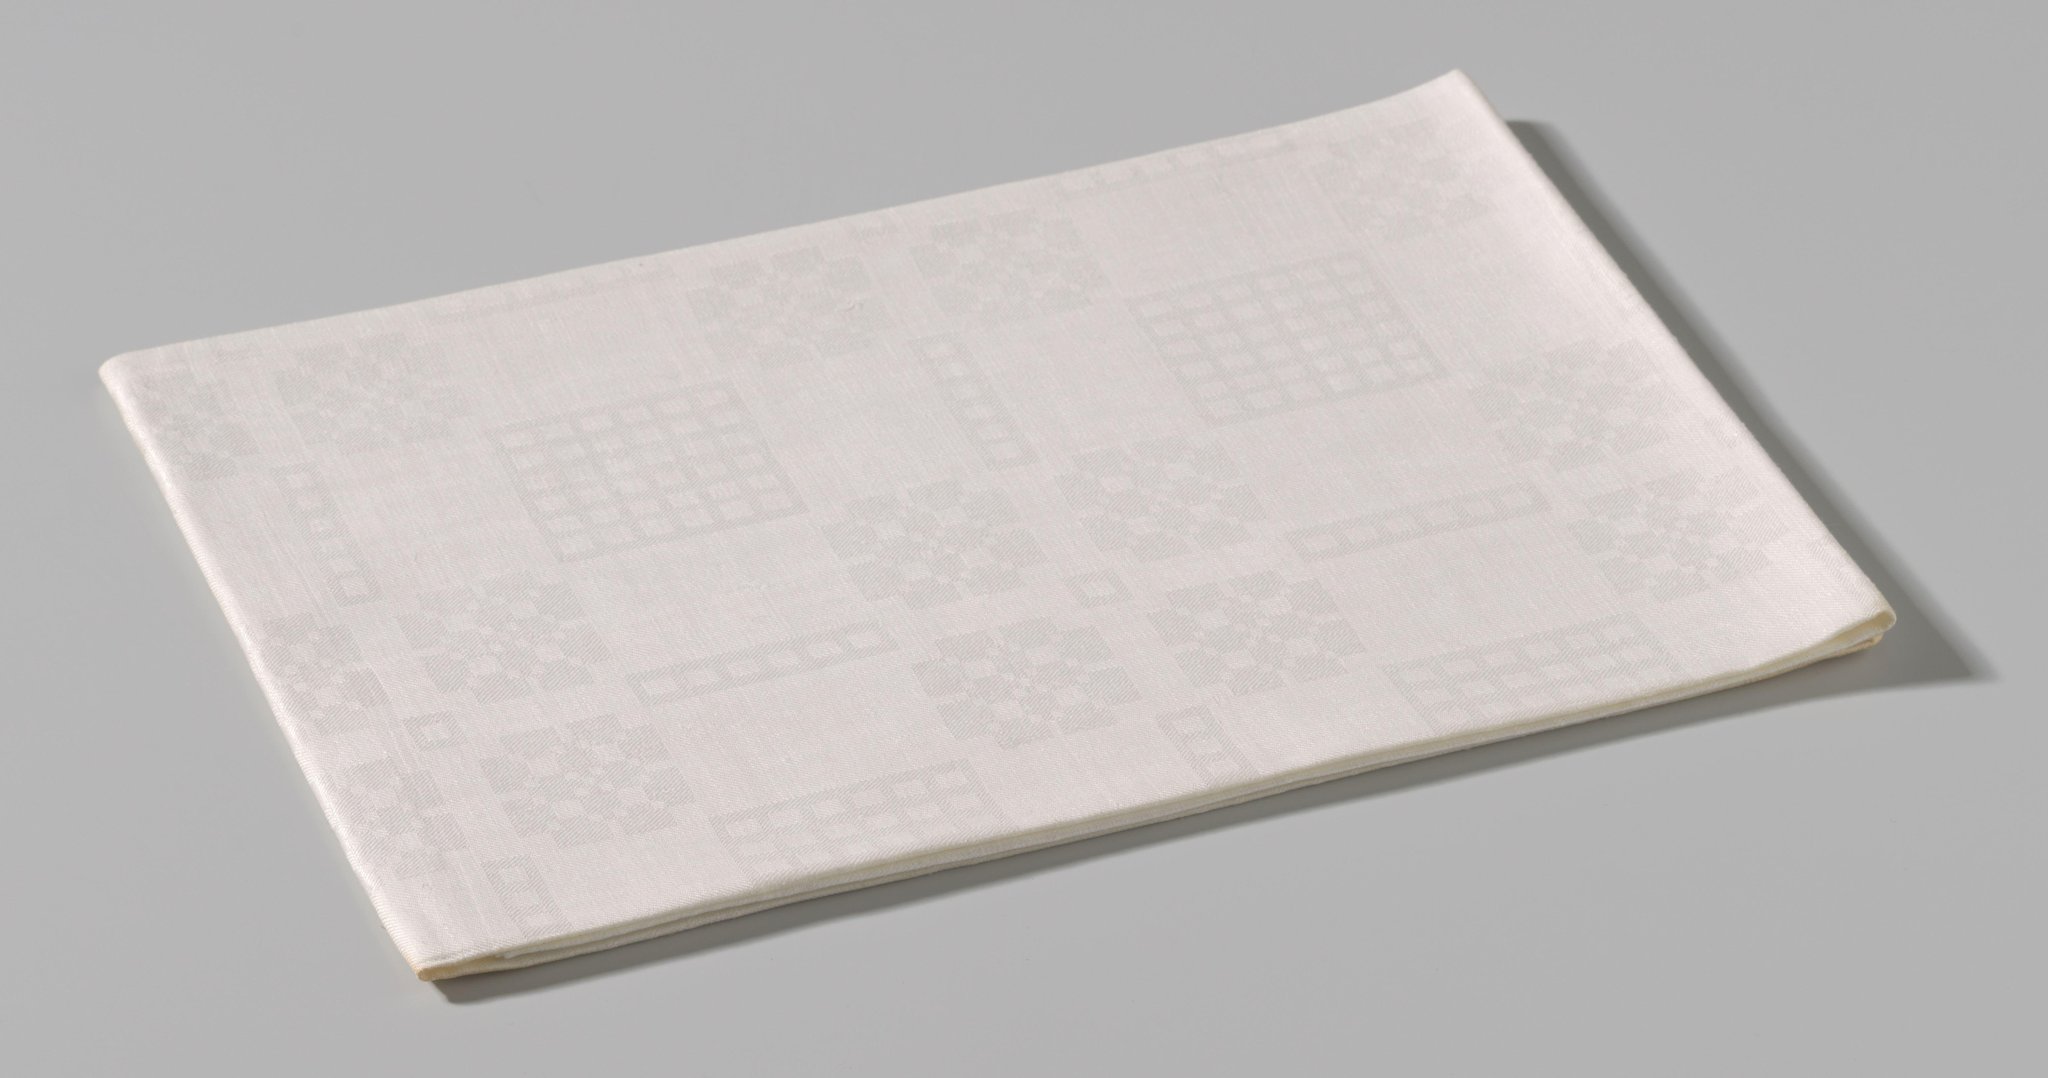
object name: napkin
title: Servet met pellenpatroon met wafelruit en bloemvorm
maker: Anonymous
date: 1675-1725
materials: linen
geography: northern netherlands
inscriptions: mark: ‘BS’, mark: ‘48’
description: Servet van wit linnen met een pellen patroon in keper, een wafelruitje met een soort bloem, merk BS en 48.